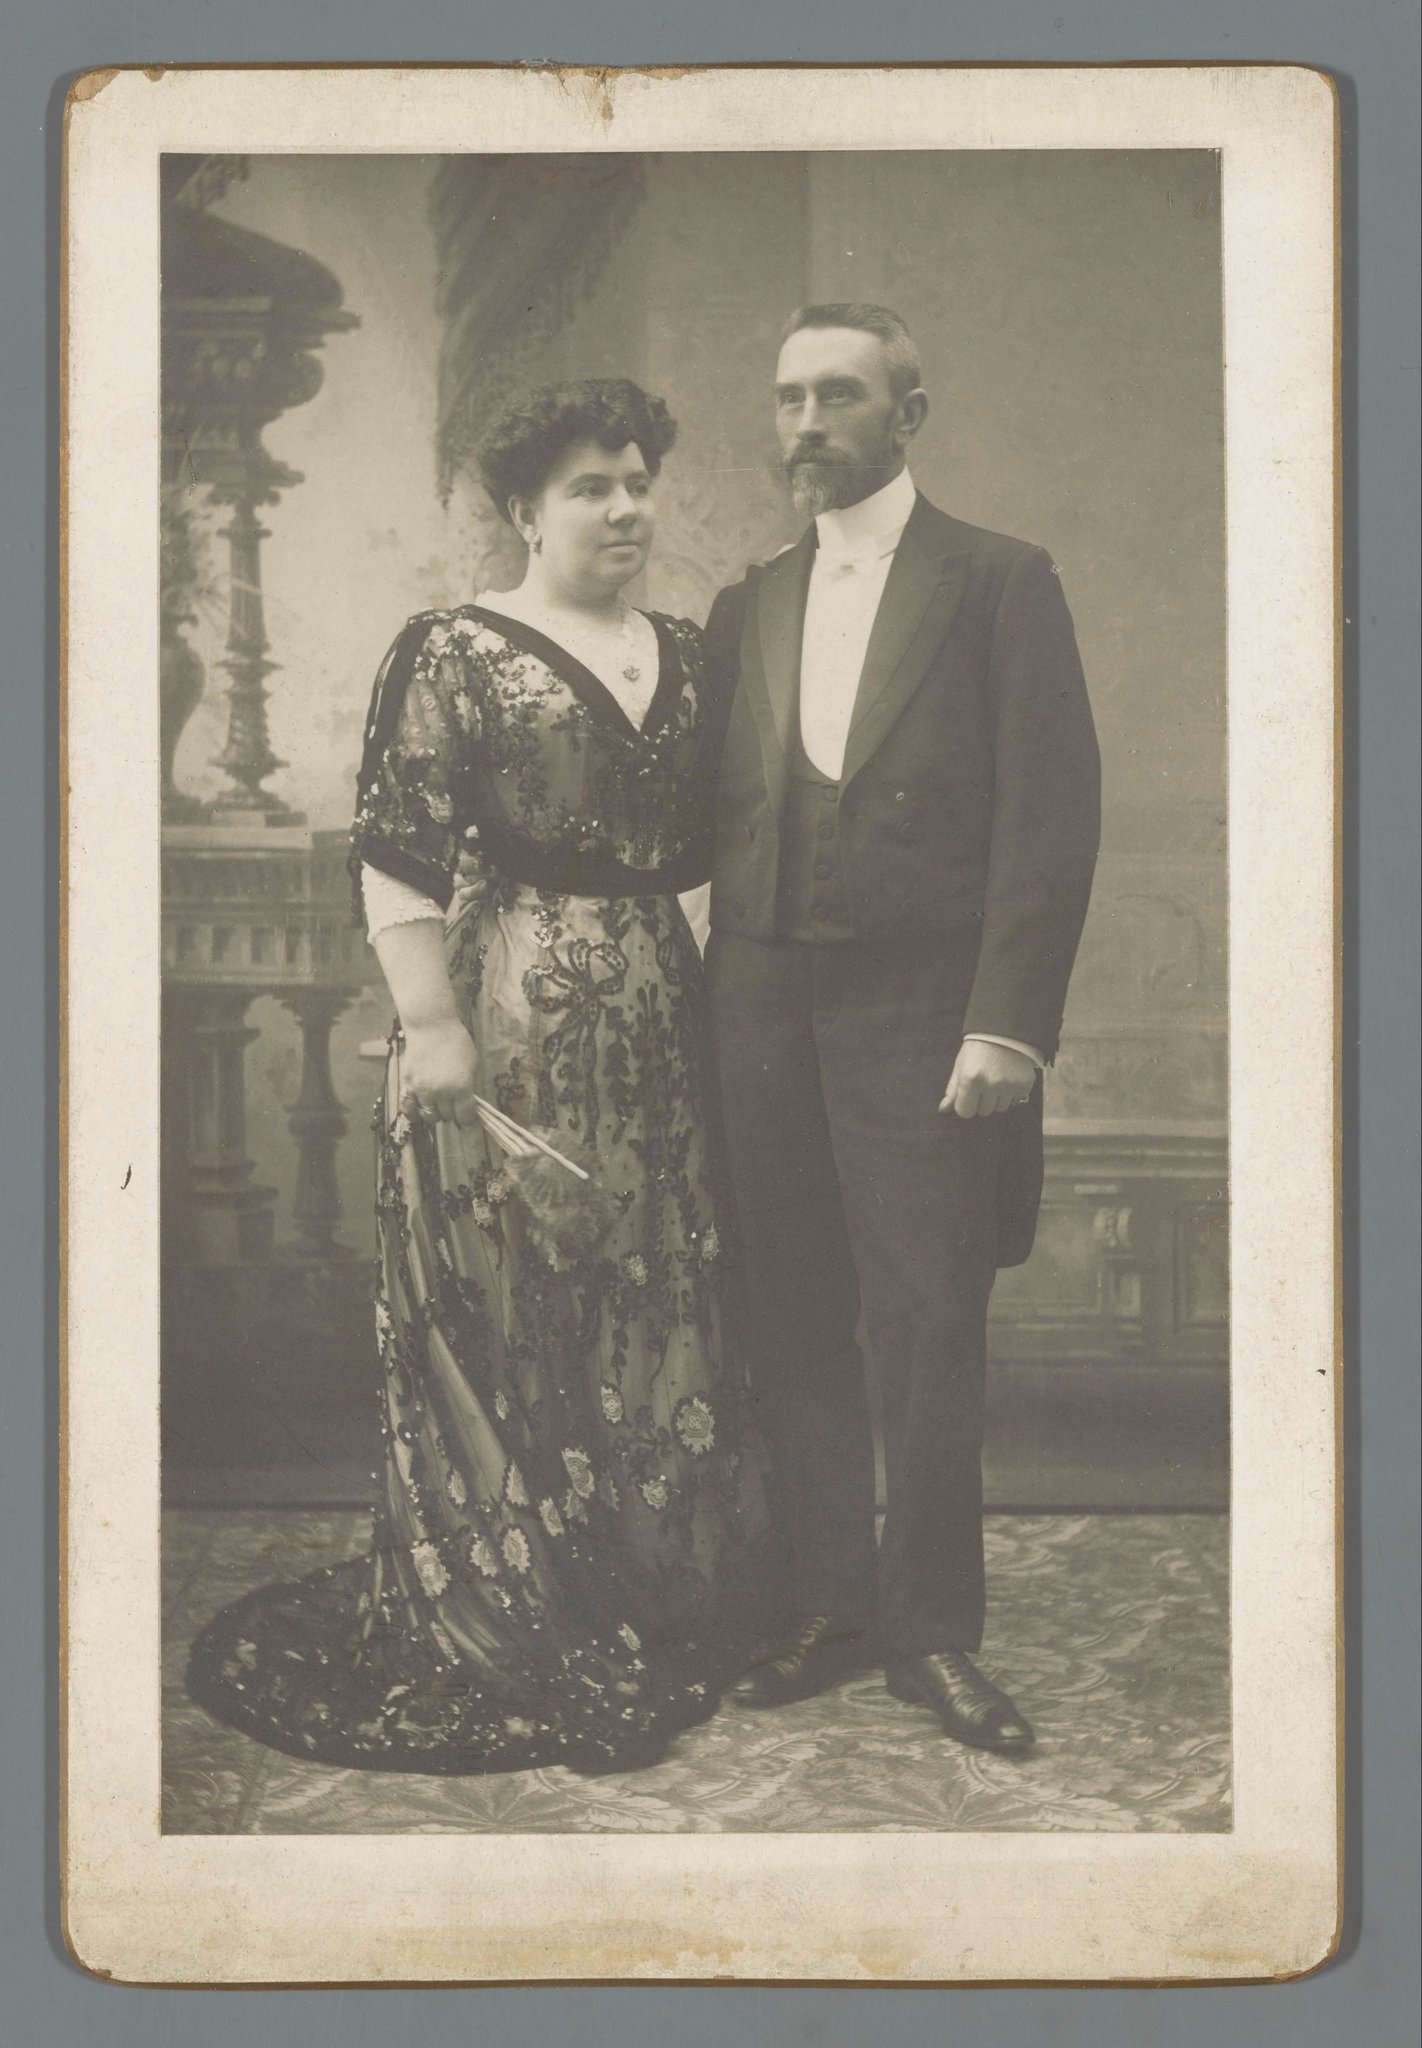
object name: cabinet photograph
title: Dubbelportret van een paar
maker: Anonymous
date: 1909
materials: cardboard, photographic support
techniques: matte daylight collodion silver print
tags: fan, couple of lovers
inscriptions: : ‘Souvenir affectueux à ma cher Amie Eva, Julie, 28 Décembre 1909’